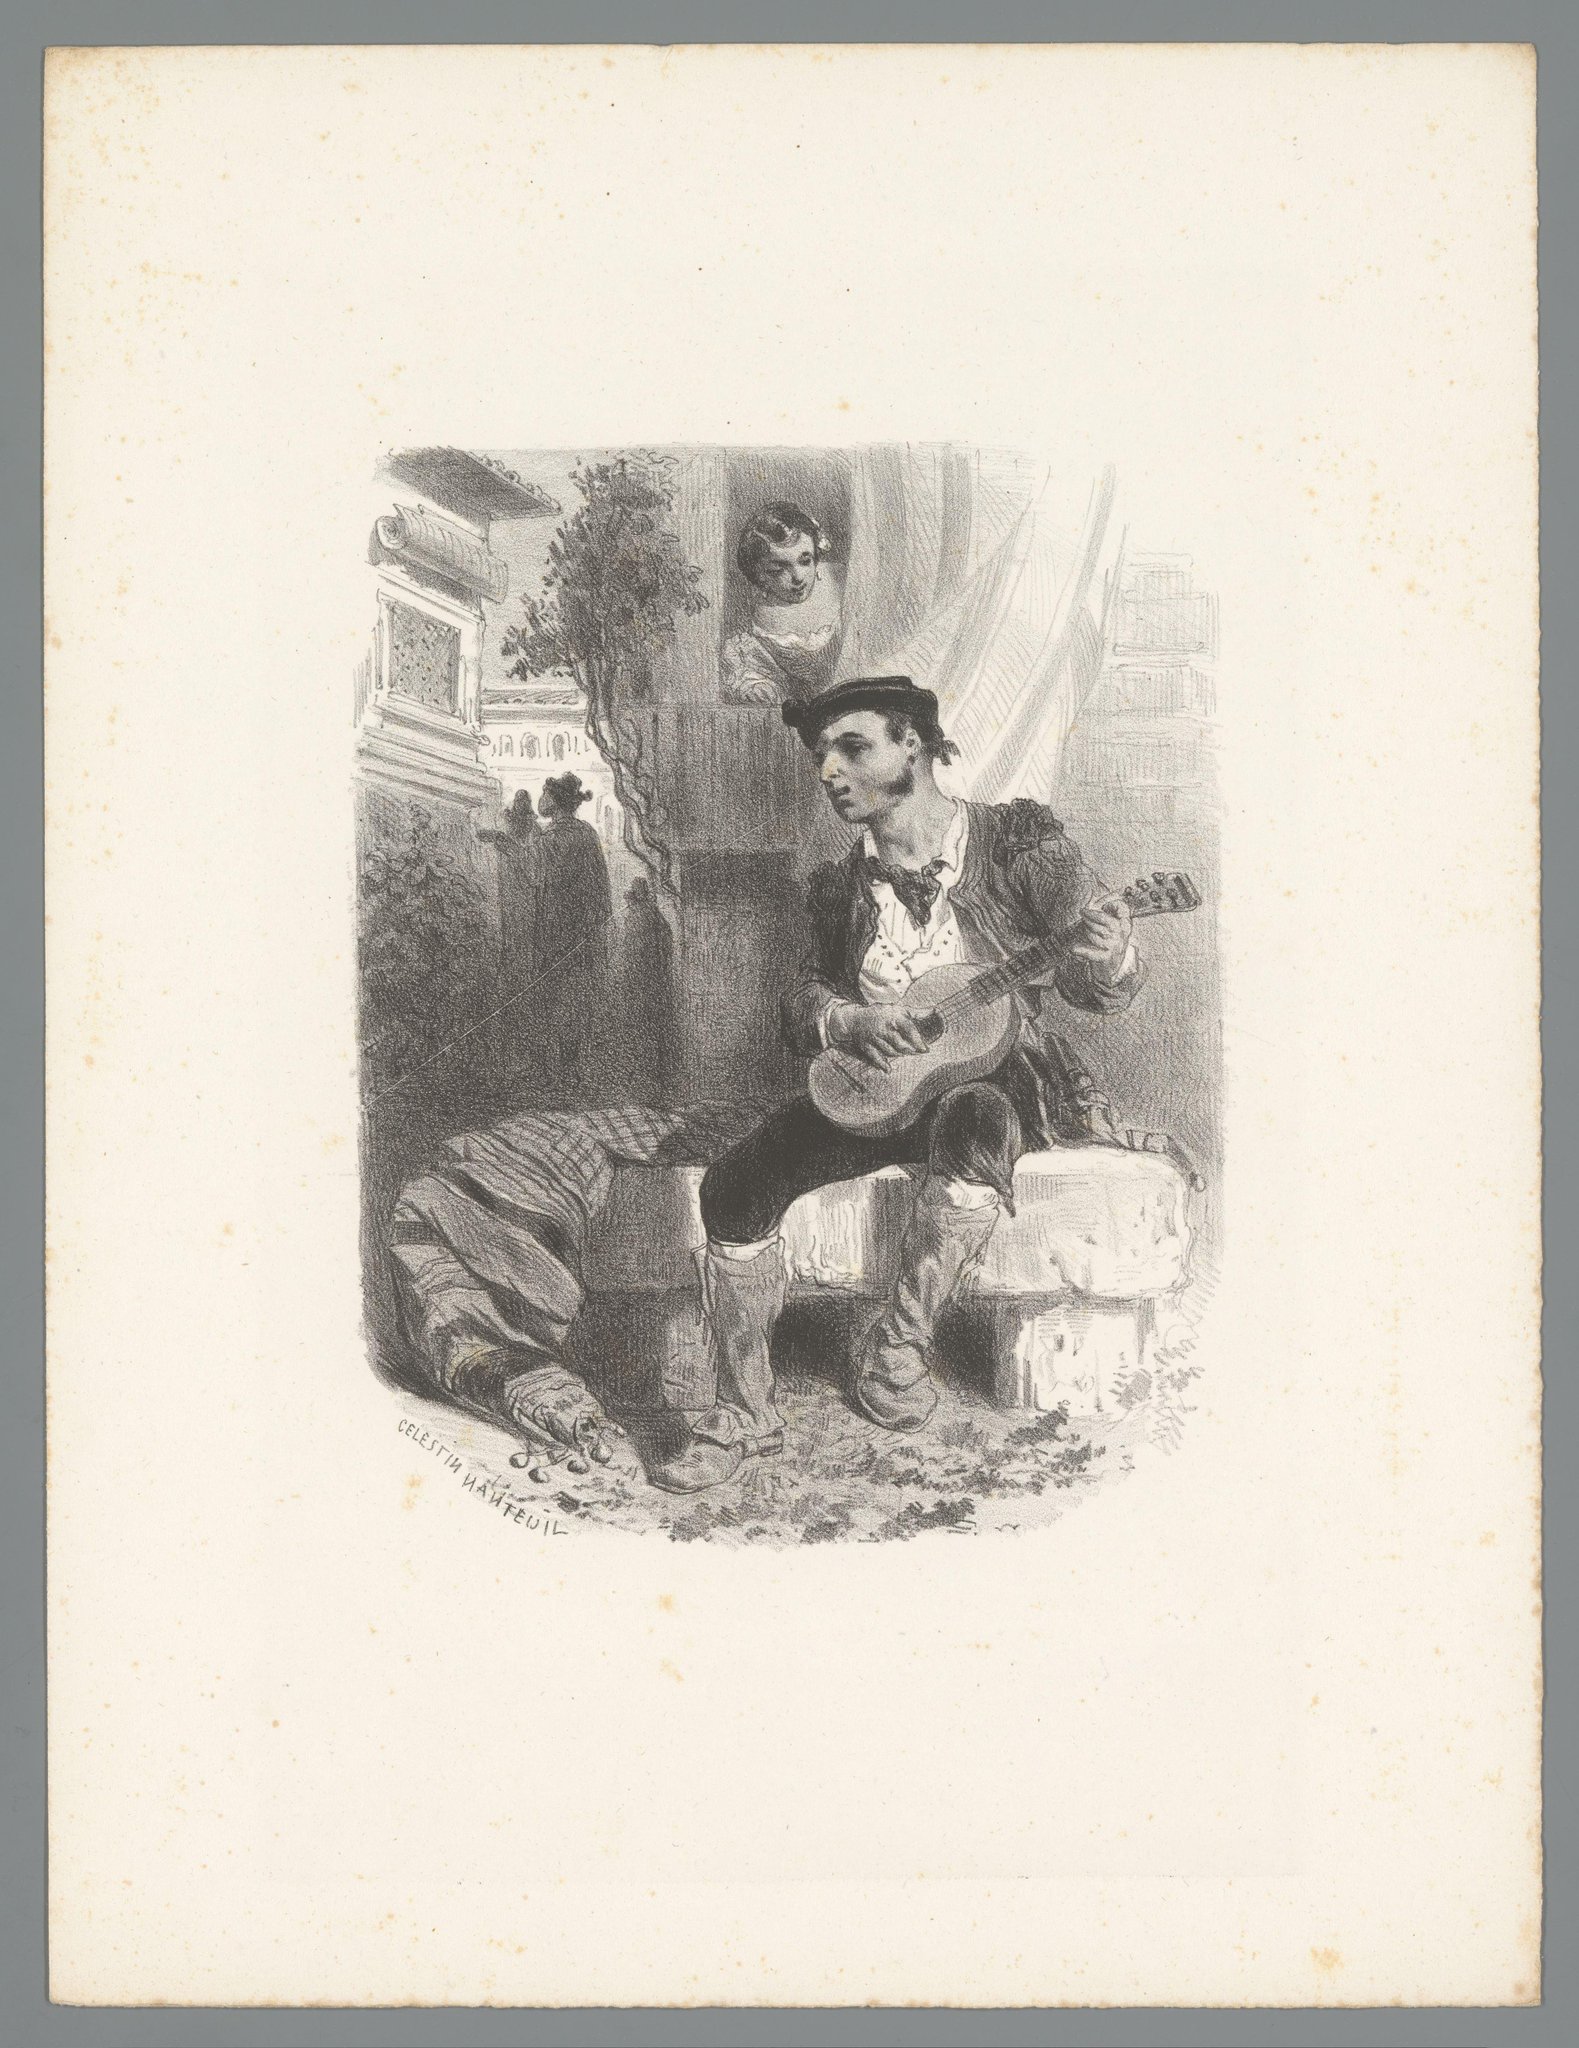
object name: print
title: Man spelend op een luit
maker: célestin françois nanteuil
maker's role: print maker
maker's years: 1813-1873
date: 1823-1873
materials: paper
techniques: lithograph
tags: female sex; woman, adult man, balcony, lute, and special forms of lute, e.g.: theorbo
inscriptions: collector's mark: Lugt 964